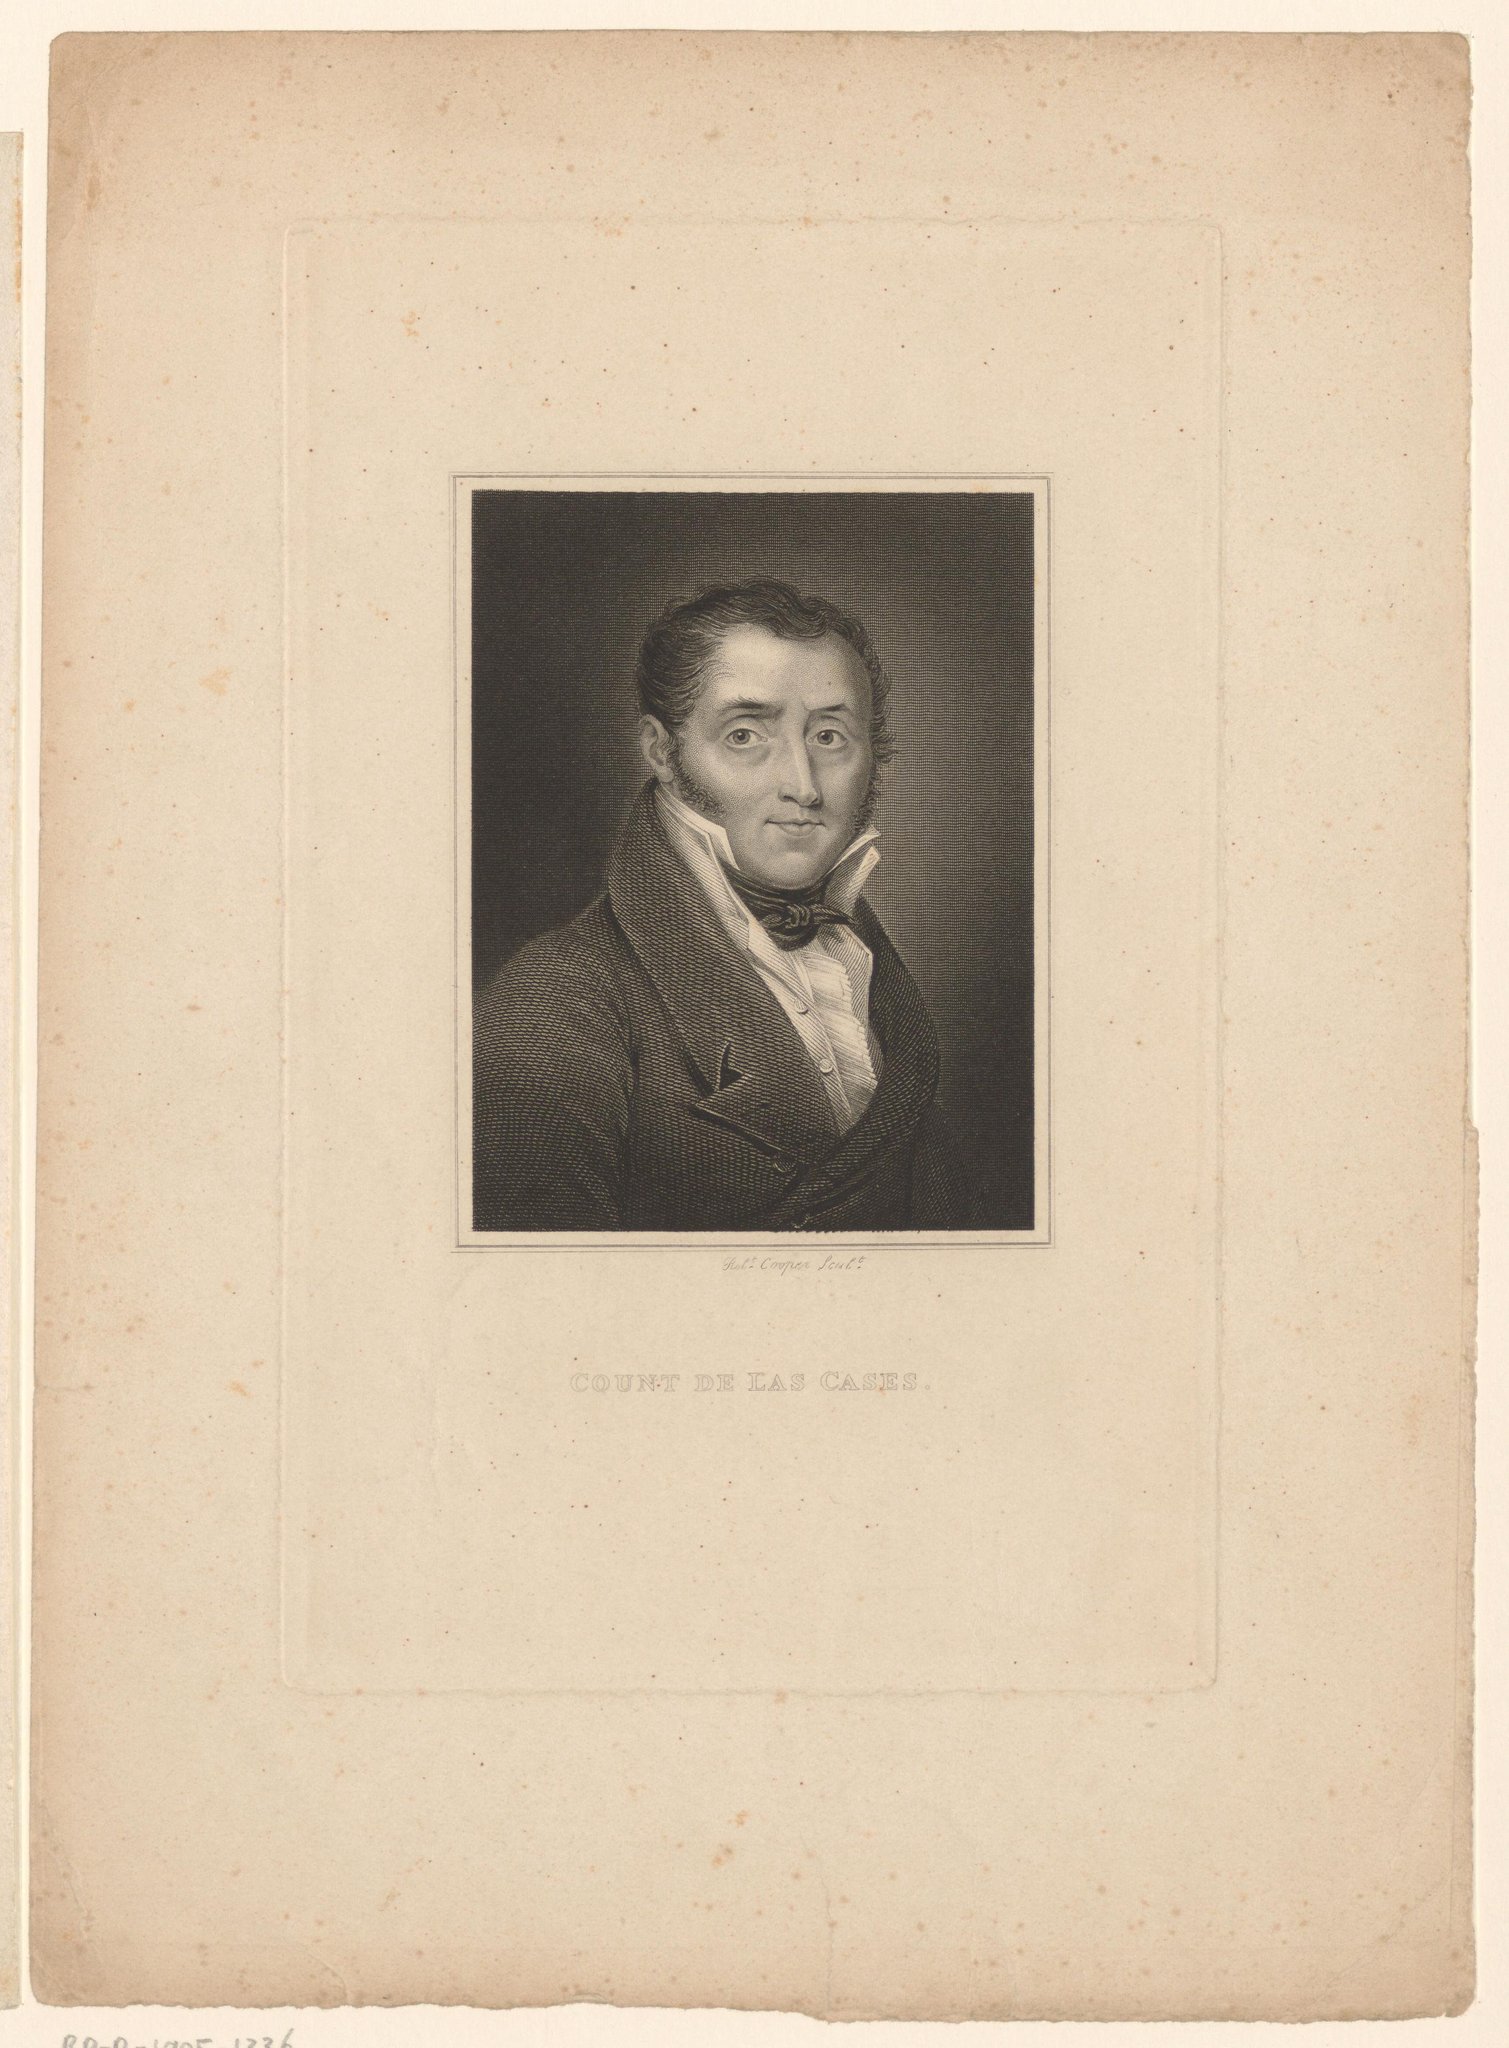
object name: book illustration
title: Count de Las Cases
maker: robert cooper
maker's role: print maker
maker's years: -1839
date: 1855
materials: paper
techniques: etching, engraving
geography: london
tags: politician, historical persons, portrait of a writer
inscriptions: collector's mark: Lugt 2228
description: Prent waarschijnlijk uit: Cases, Emmanuel de Las. Memoirs of the Life, Exile, and Conversations of the Emperor Napoleon. New York: Redfield, 1855.